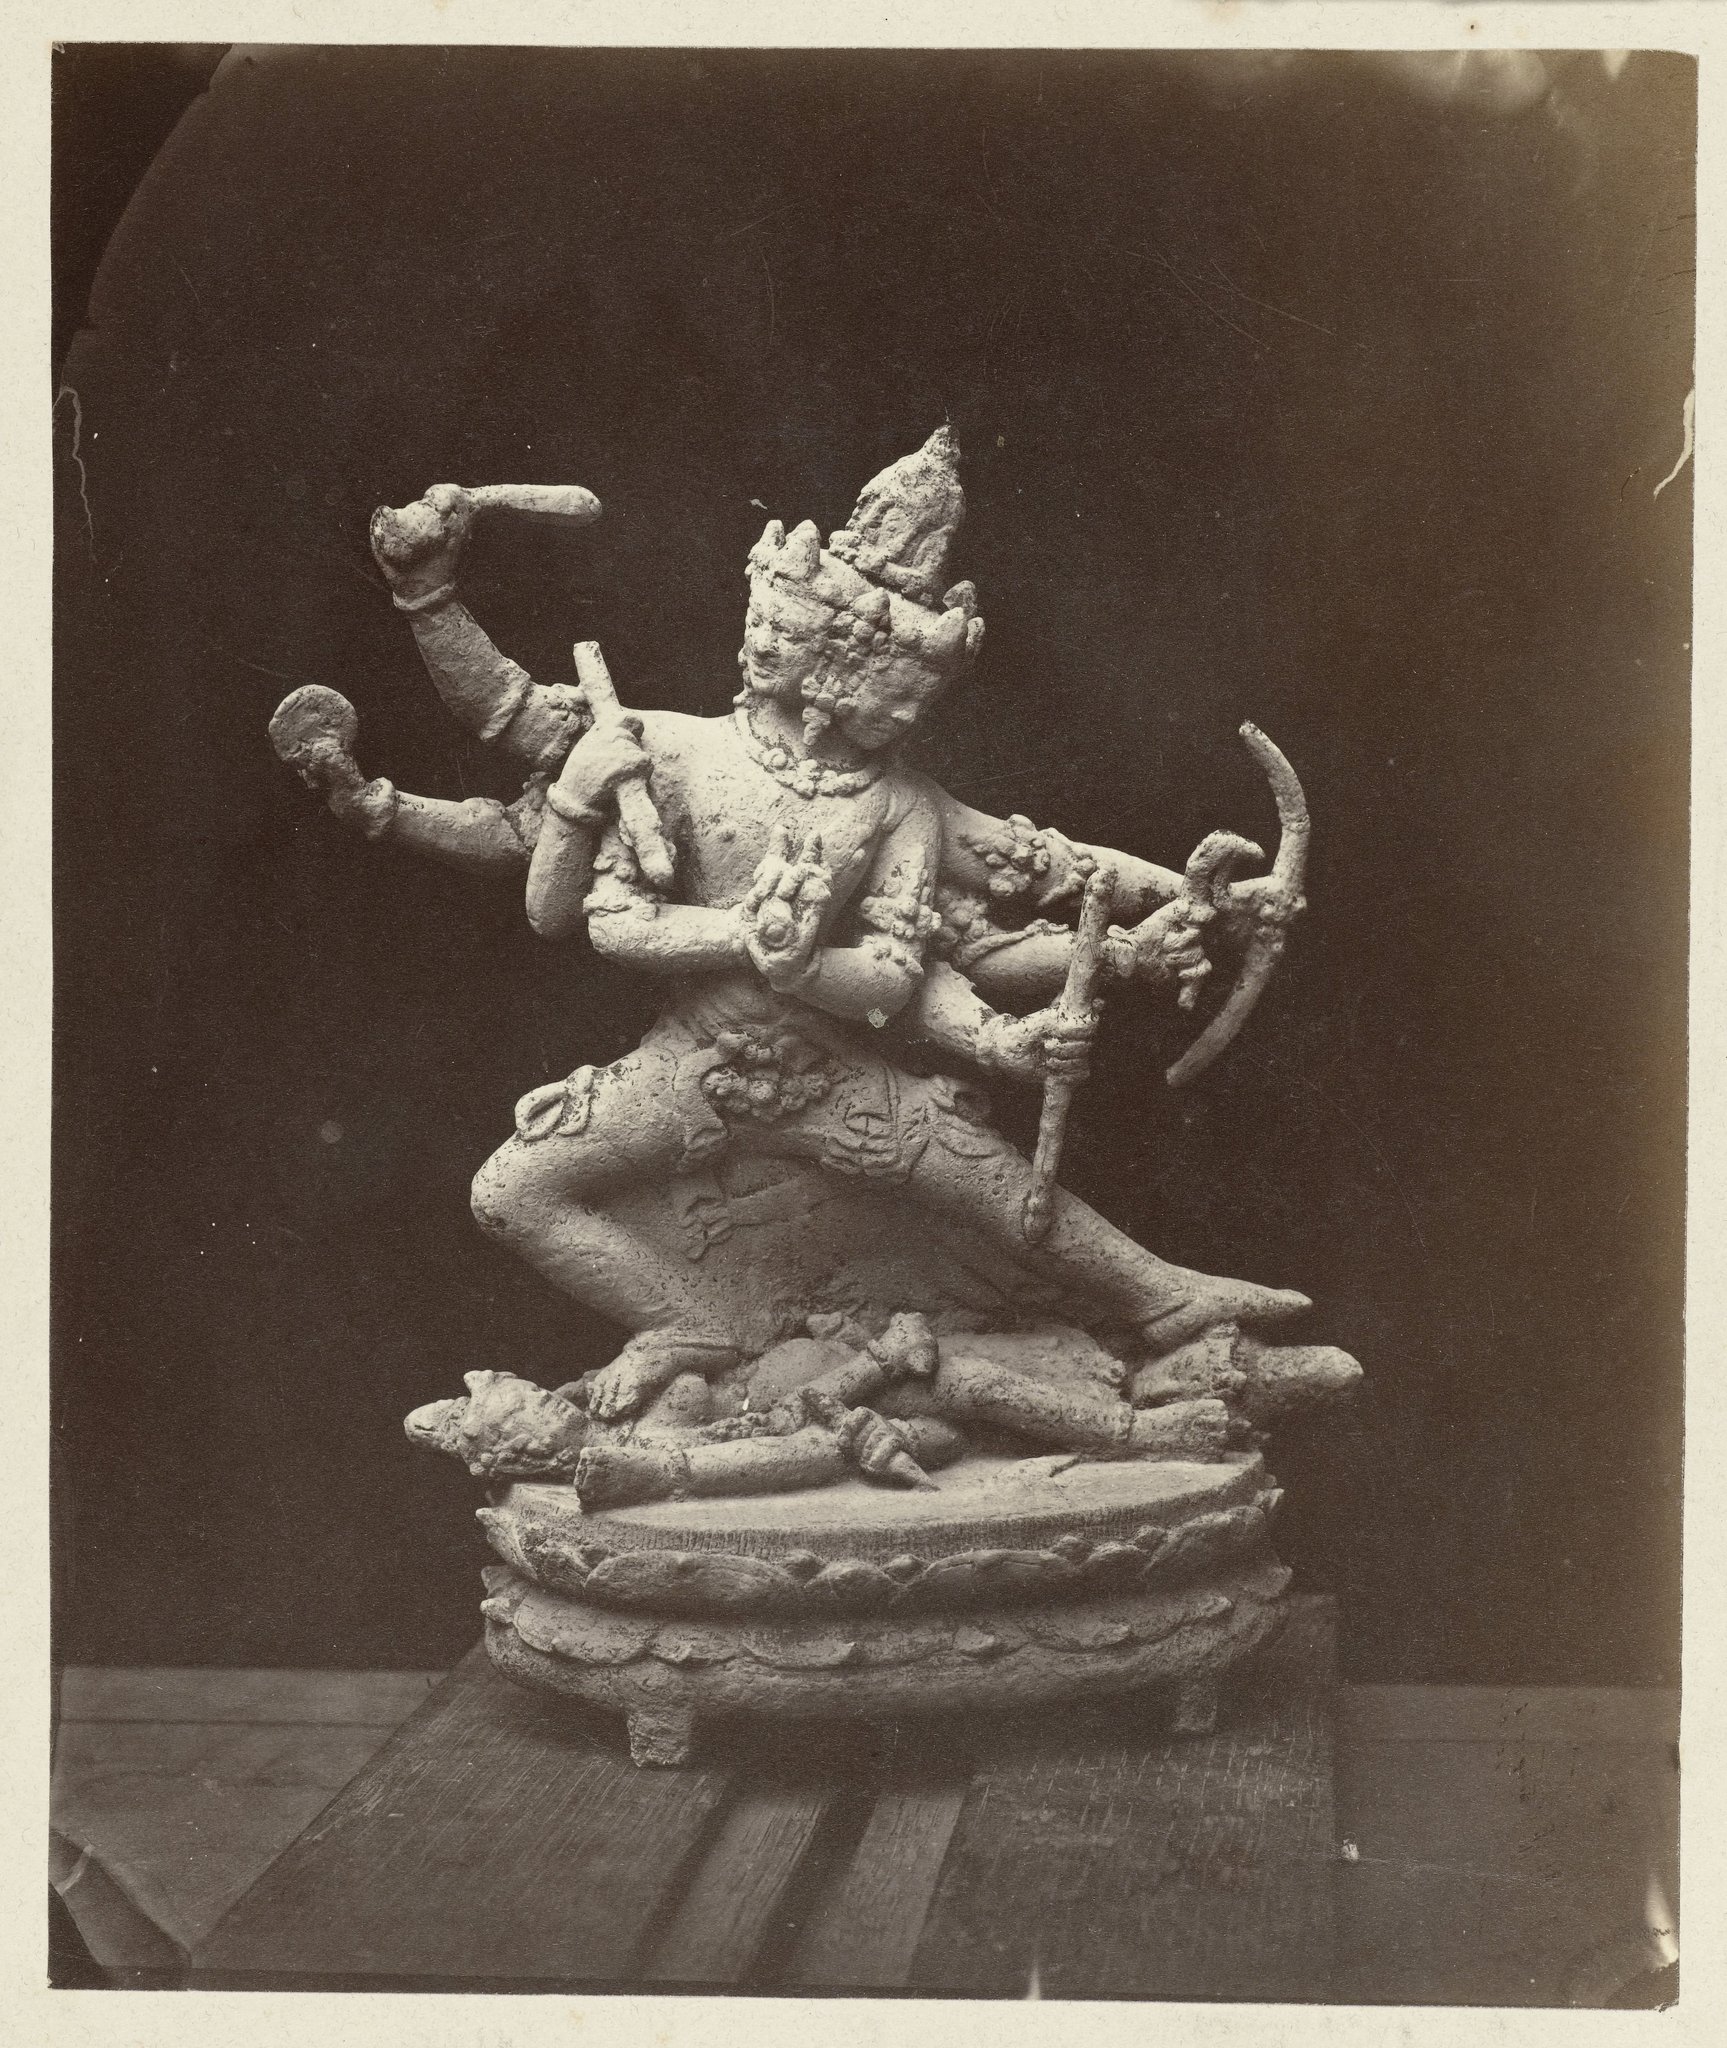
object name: photograph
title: Djokjokarta (Klaring) (r. Djokjokarta) Eight-armed bronze Trailokyavijaya dashing a corpse (Former Klaring collection). Yogyakarta, Yogyakarta district, D.I. Yogyakarta province, 9th-10th century.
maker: isidore kinsbergen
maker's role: fotograaf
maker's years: 1821-1905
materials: cardboard, paper, photographic support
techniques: albumen print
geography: java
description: veroveraar van drie werelden en staand op twee lichamen.